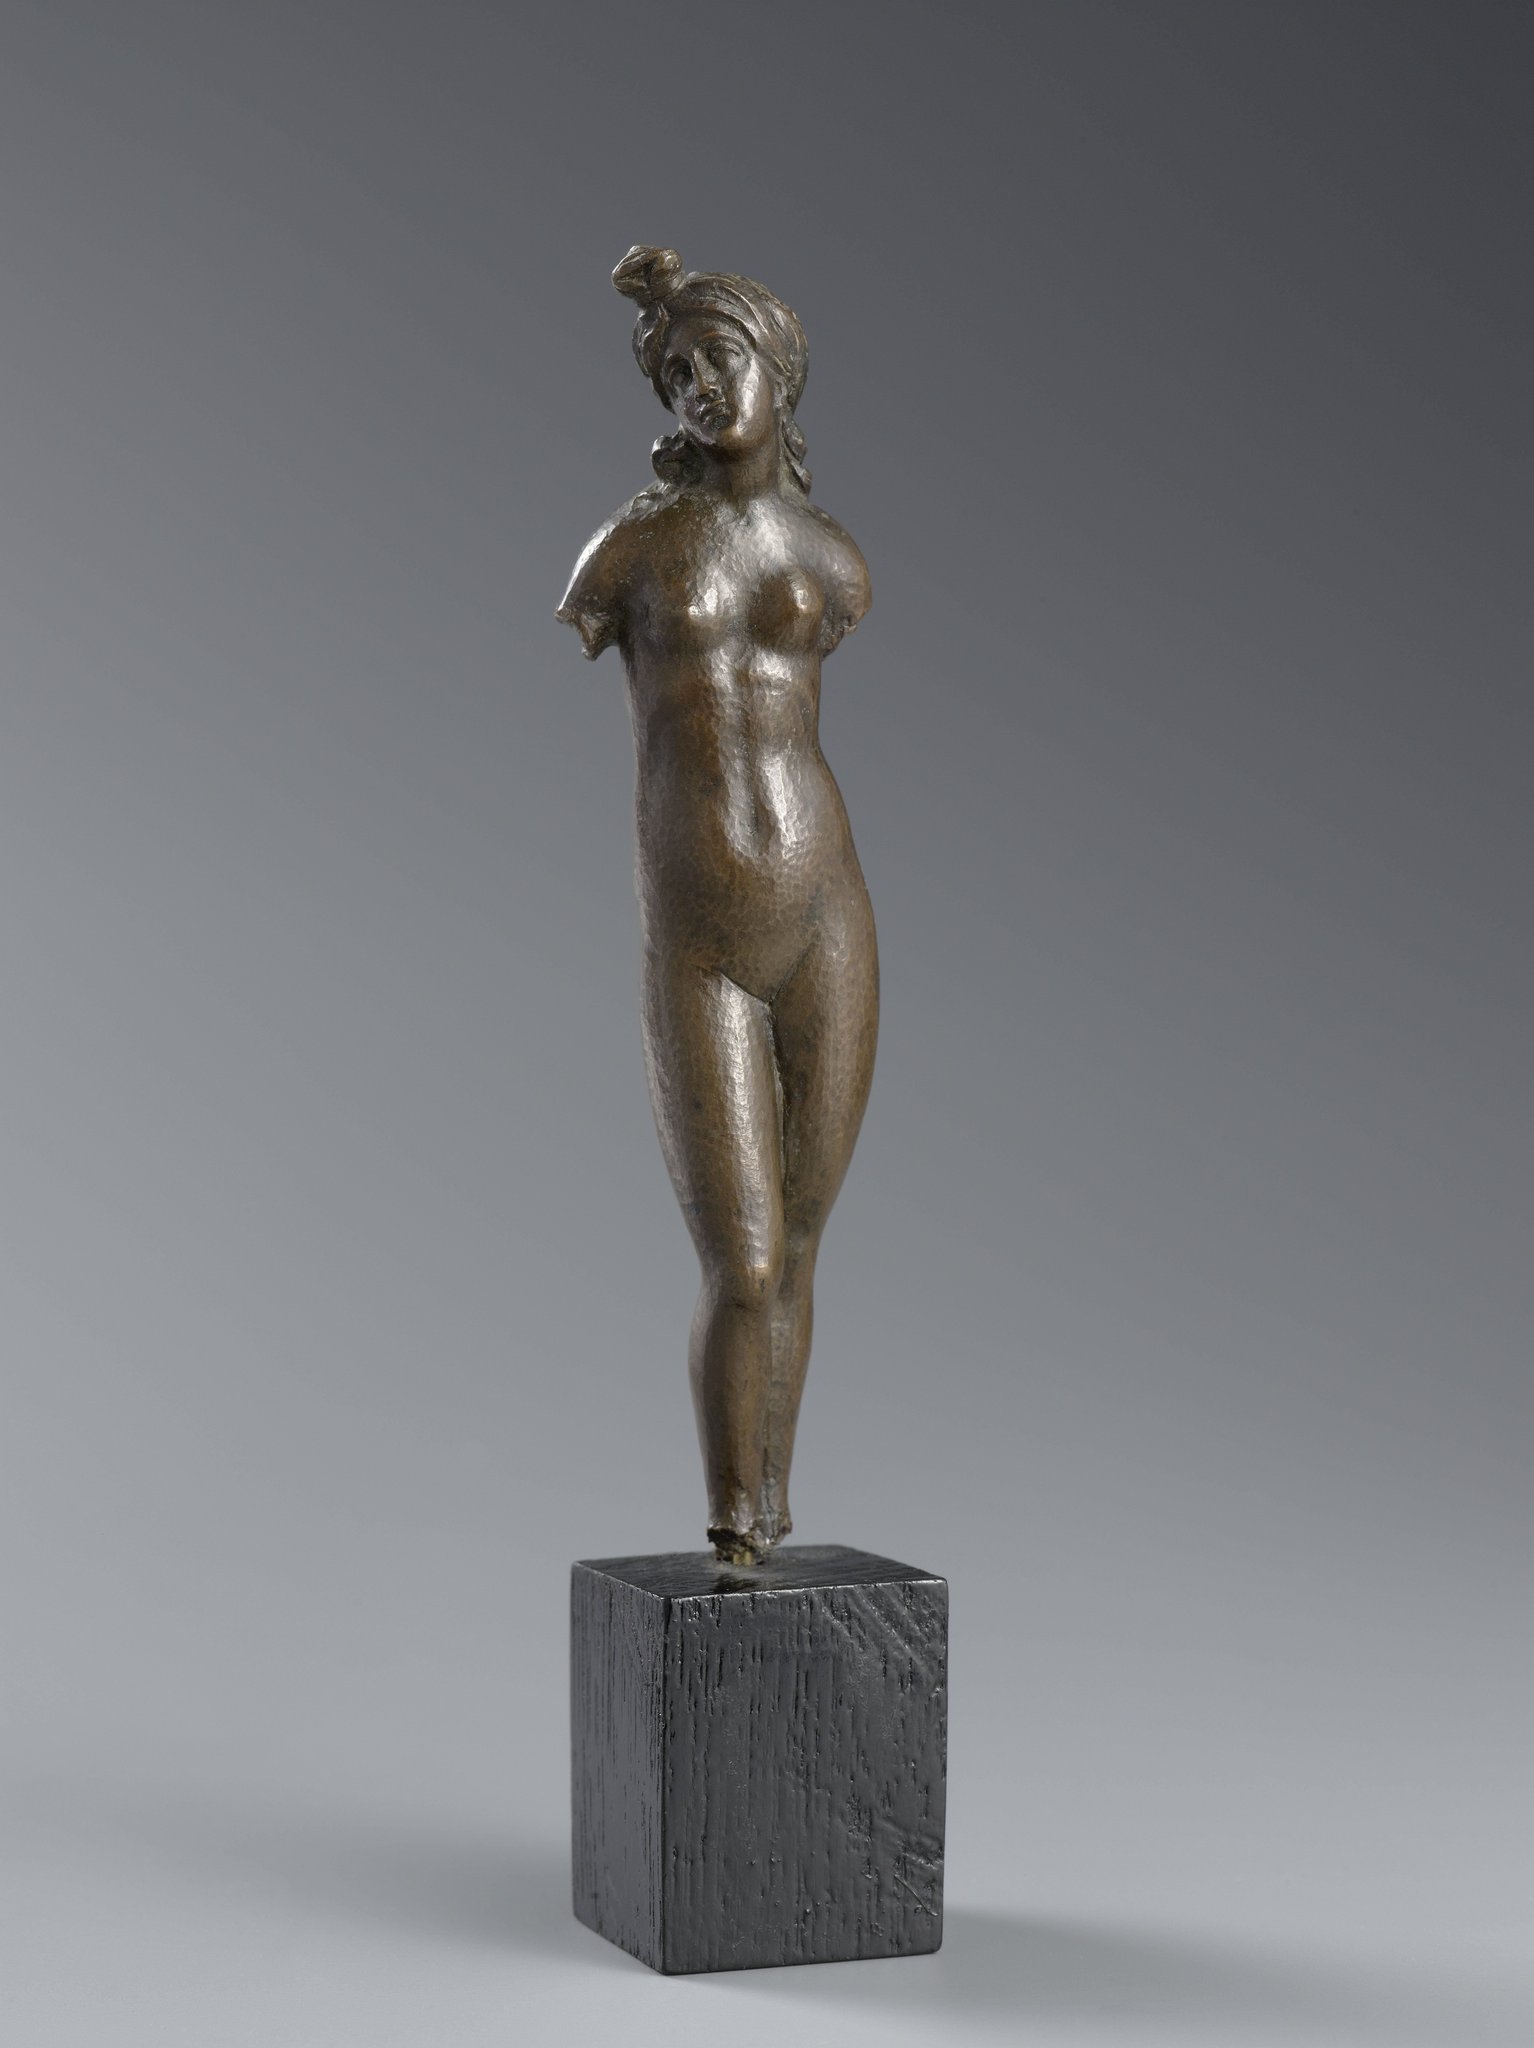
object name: sculpture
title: Venus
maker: elias de witte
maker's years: 1548-1574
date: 1570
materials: bronze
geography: florence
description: In the 18th century this small Venus was at the Museo Ridolfini-Corazzi in Cortona (Italy), a renowned collection of Etruscan and Roman art. It was then considered an ancient Roman statuette, but is now attributed to the Fleming Elias de Witte, who worked in Florence. By omitting the arms and roughening the surface, he deliberately gave Venus the appearance of an excavated Roman bronze figurine.